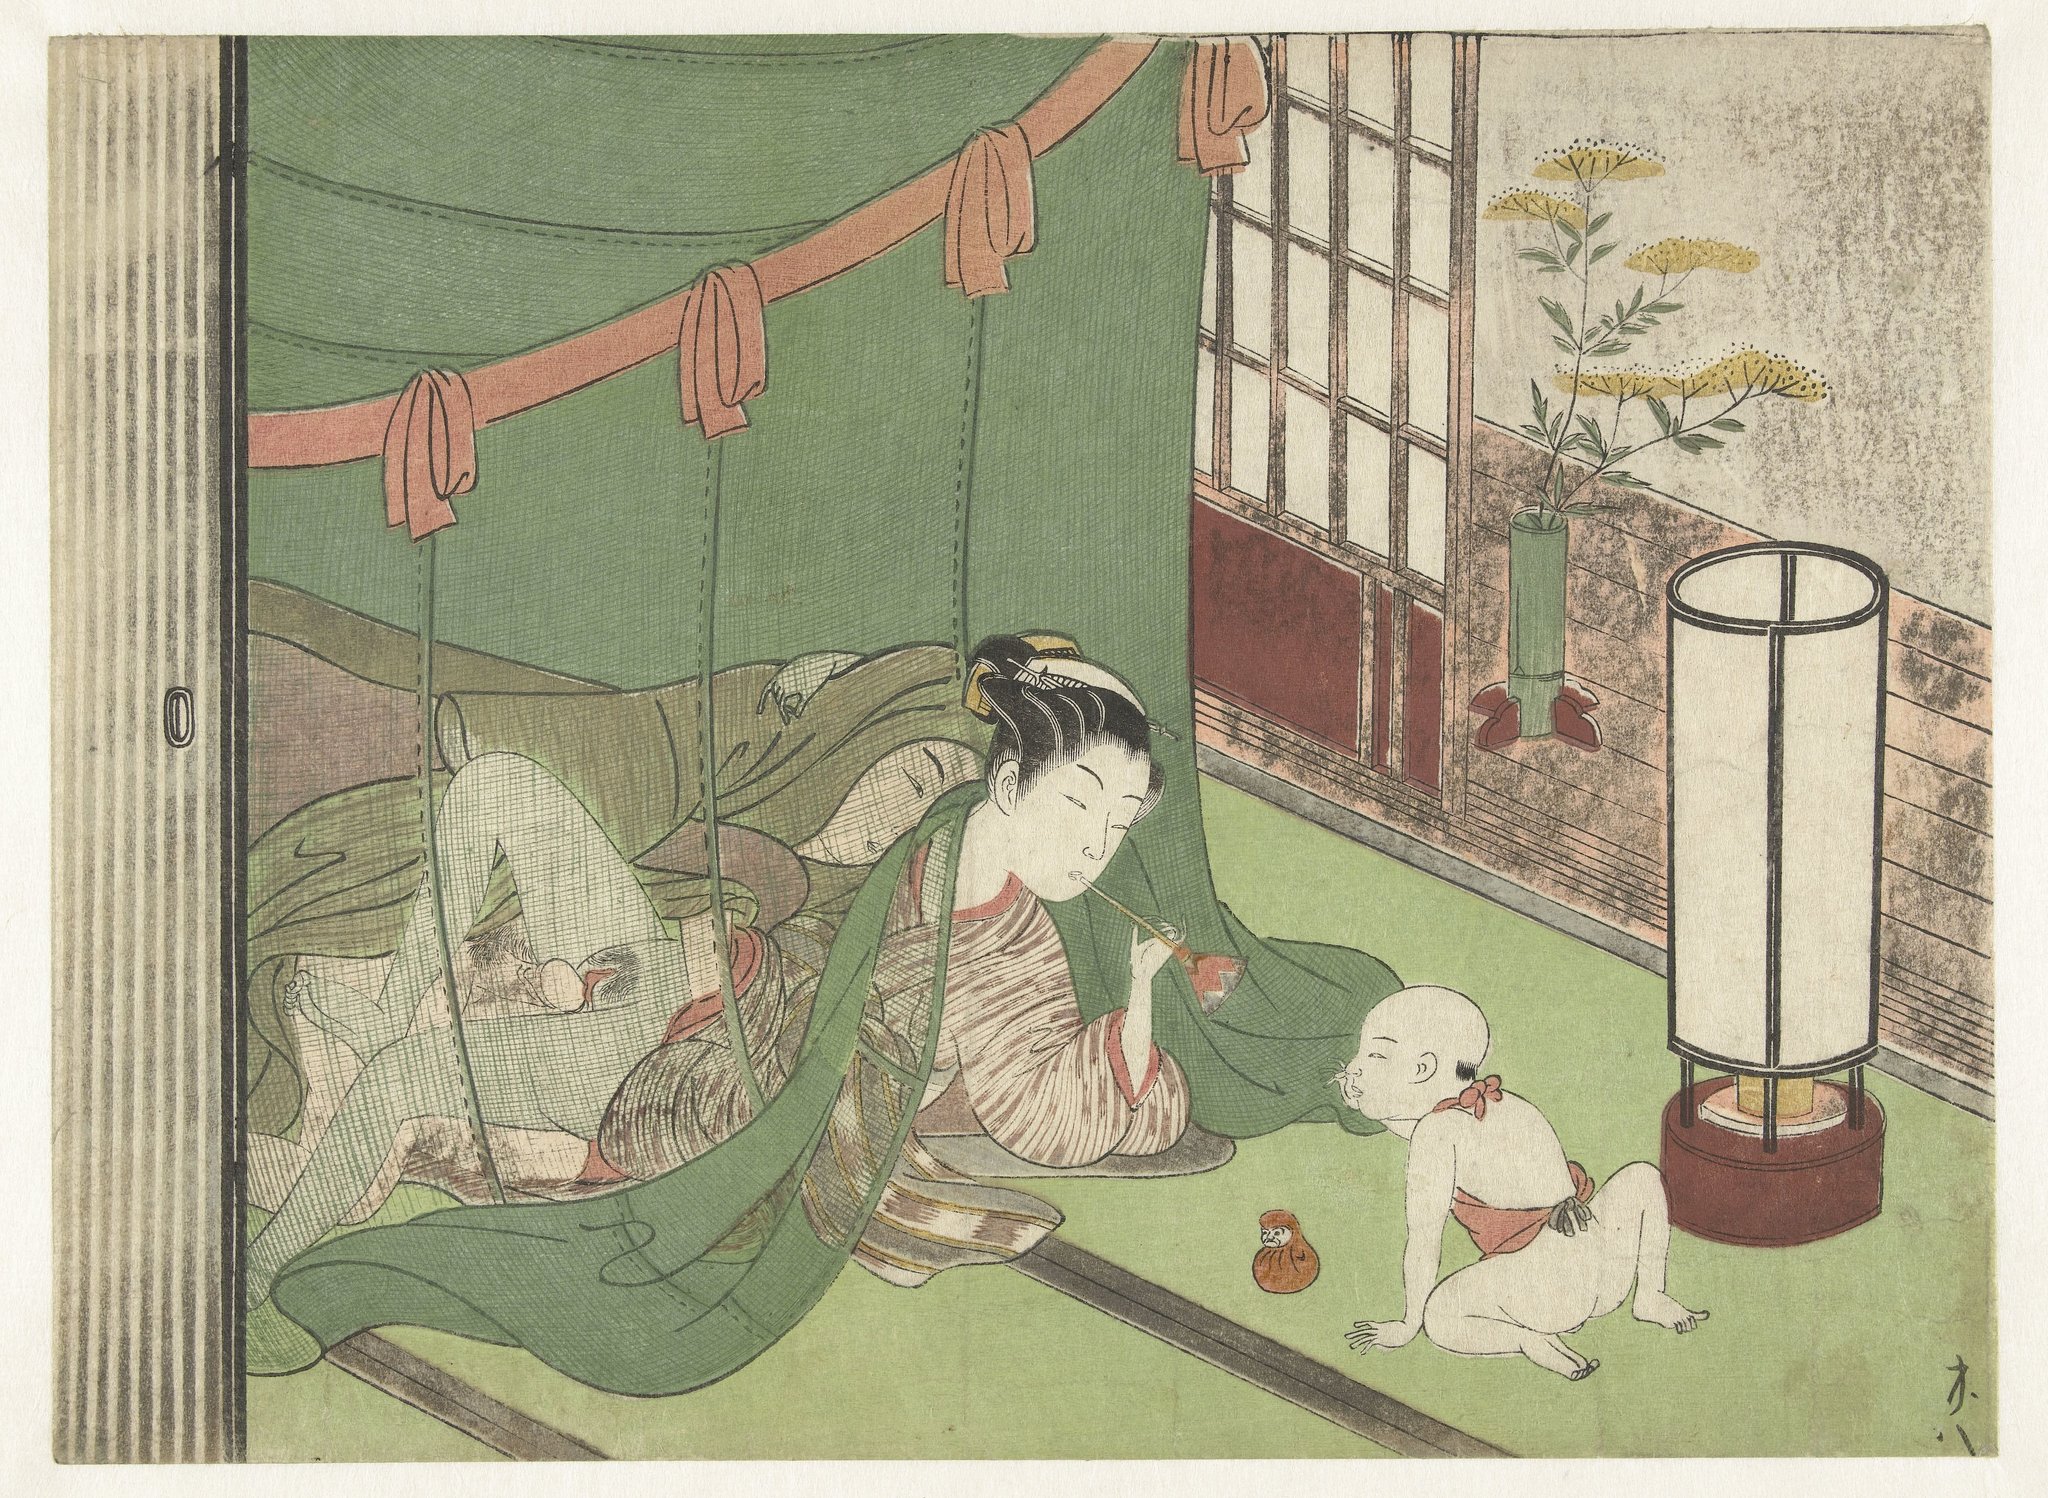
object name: shunga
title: Liefdespaar en kind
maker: suzuki harunobu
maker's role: print maker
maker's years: 1725-1770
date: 1768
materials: paper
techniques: woodcut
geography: japan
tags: coitus, cohabiting, sexual intercourse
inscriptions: collector's mark: Lugt 2760, collector's mark: Lugt 2228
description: Man en vrouw bedrijven de liefde onder een muskietennet terwijl de vrouw een kind stil houdt met speelgoed. Rechts van het kind een lantaarn, waarachter zicht op de veranda.